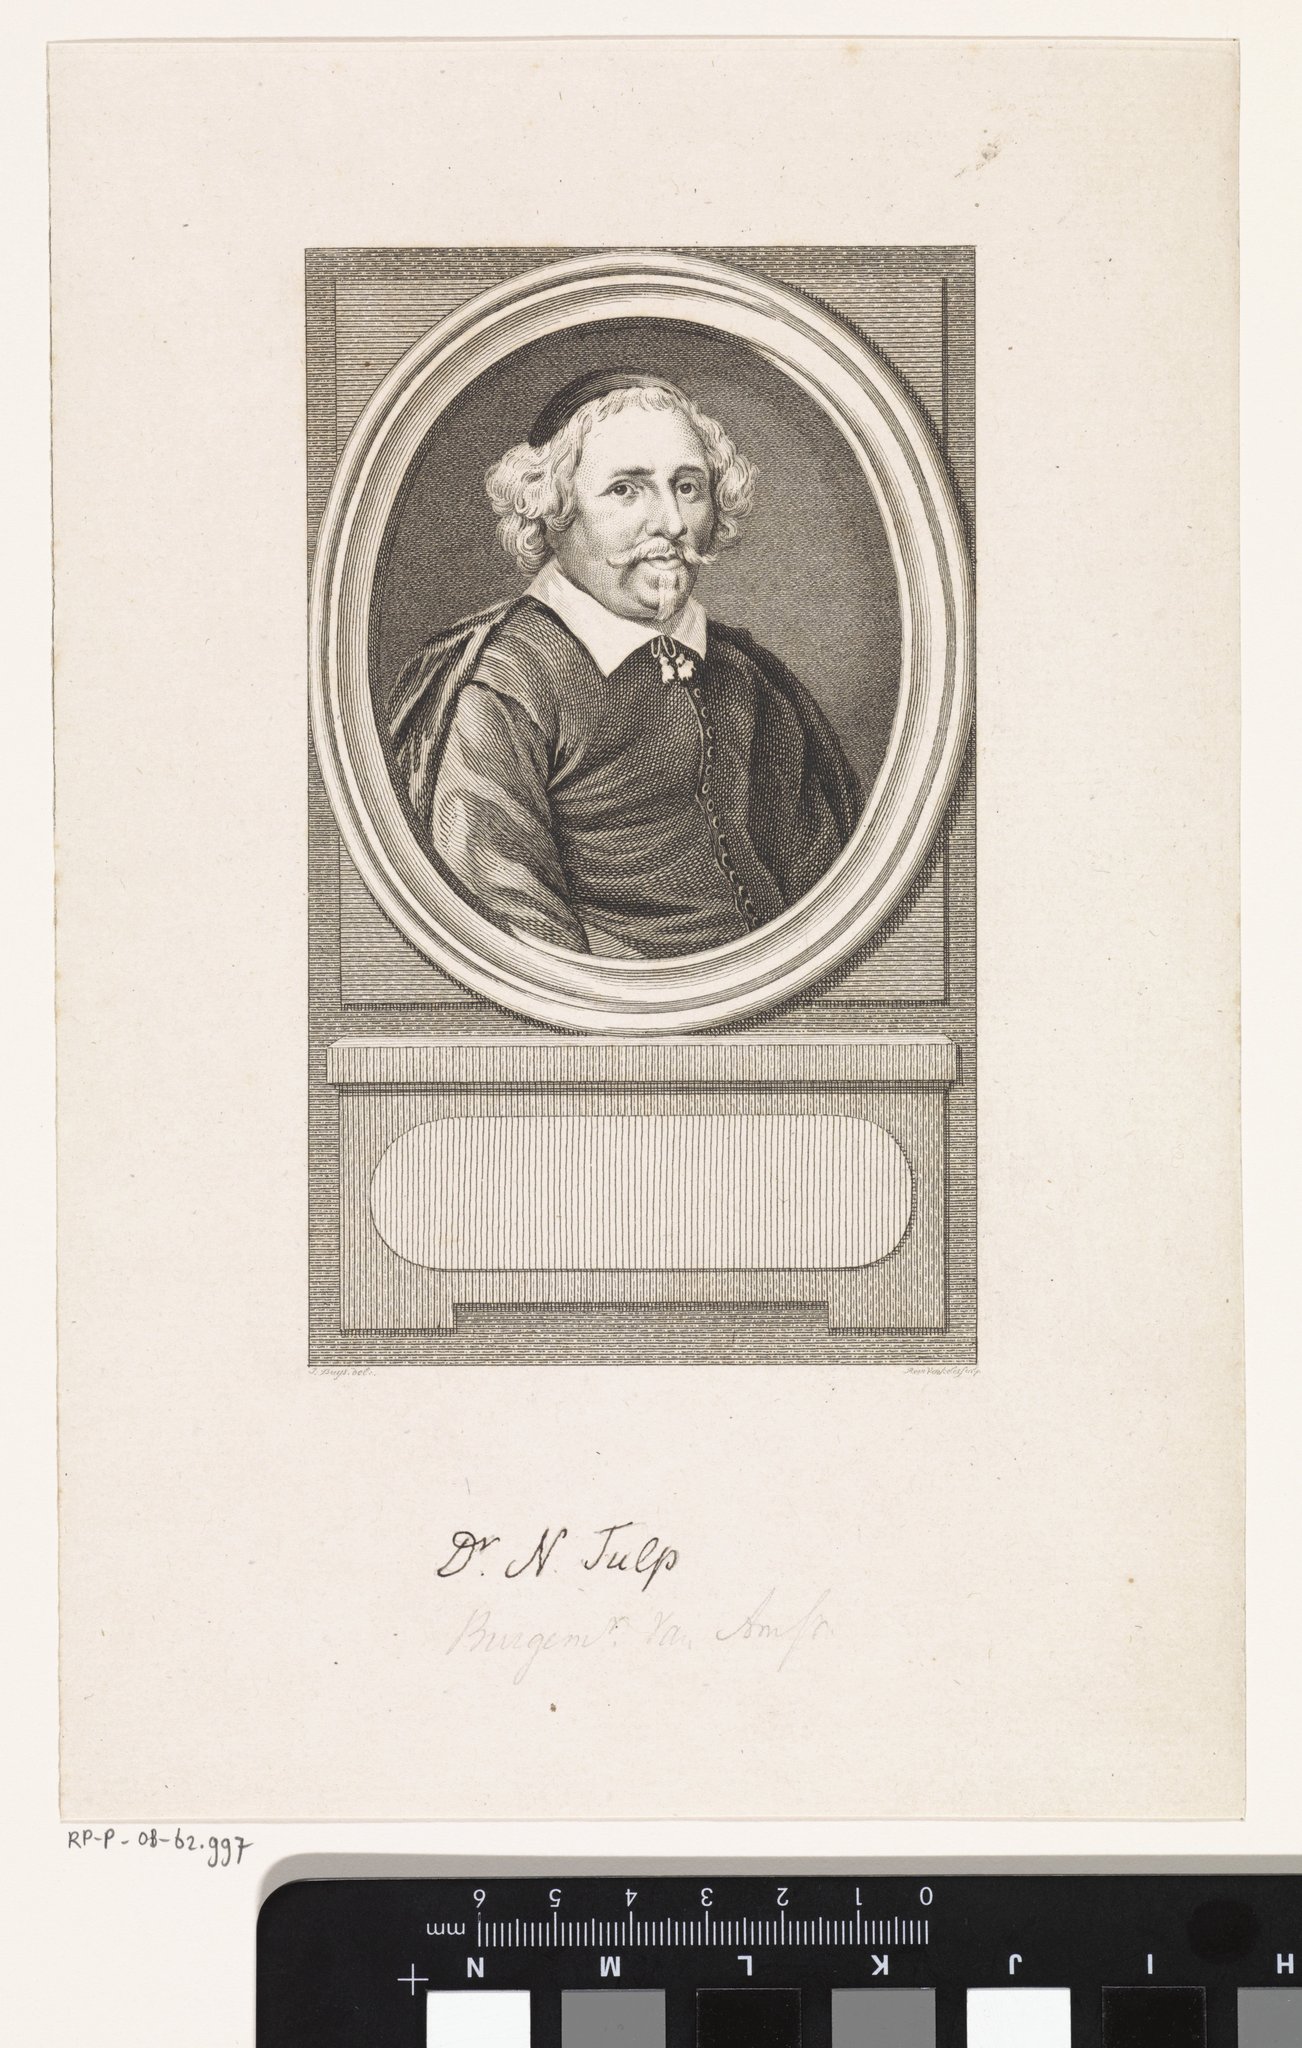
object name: print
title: Portret van Nicolaas Tulp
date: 1793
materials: paper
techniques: engraving, etching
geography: amsterdam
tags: amsterdam, mayor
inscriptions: collector's mark: Lugt 2228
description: Latere staat prent gebruikt als boekillustratie in: Kok, Jacobus. Vaderlandsch woordenboek : met kaarten, plaaten en pourtraitten. Amsterdam: Johannes Allart, 1785-1796. Deel XXIX.